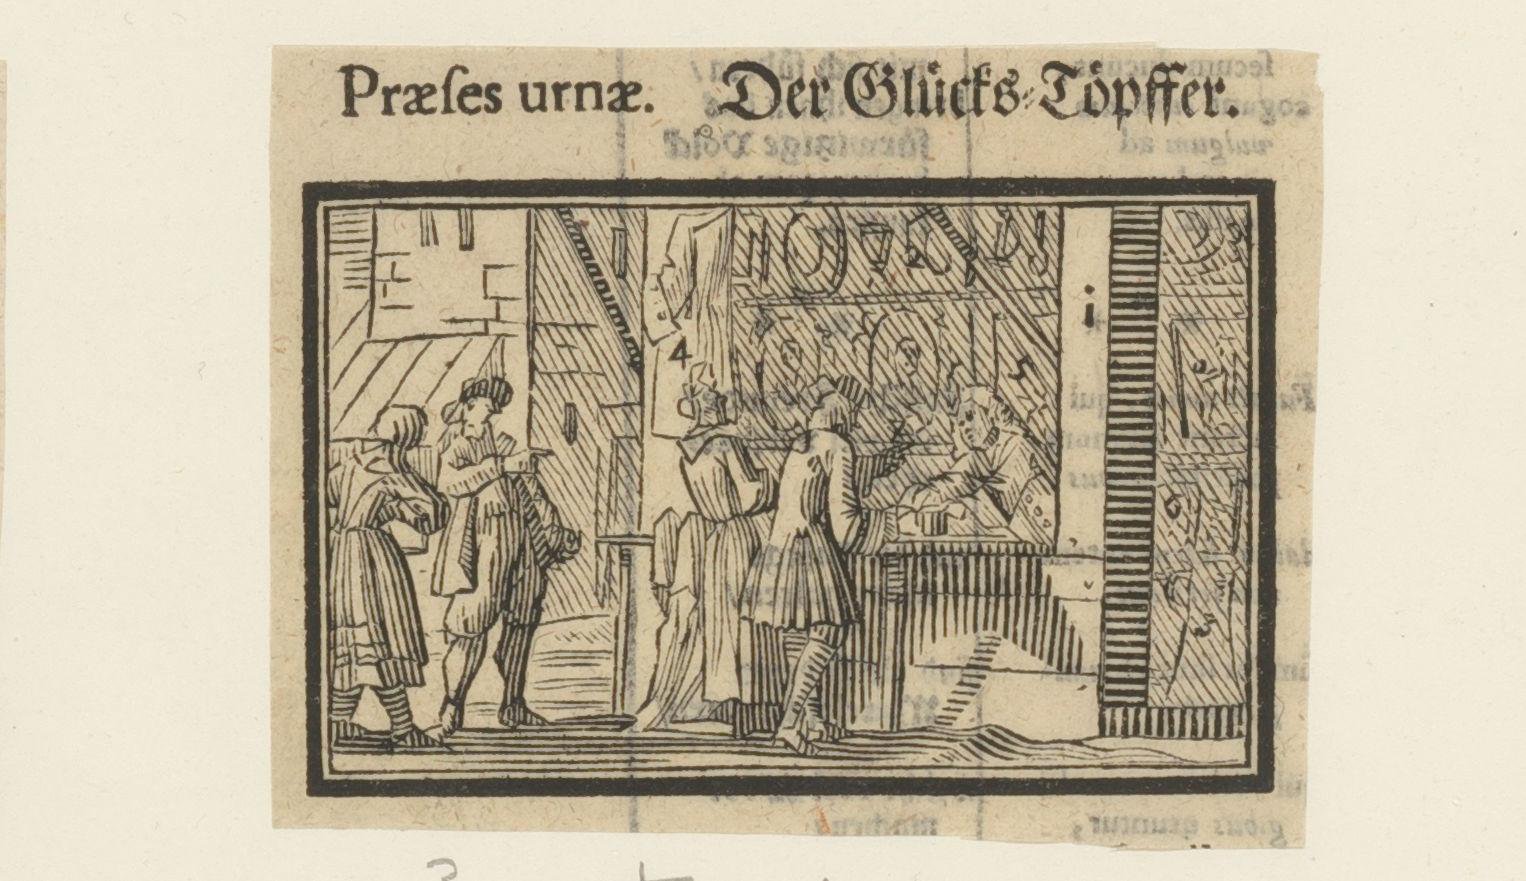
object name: print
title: Tombola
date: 1719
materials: paper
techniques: letterpress printing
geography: nuremberg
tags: raffle, lottery, games of calculation and chance, e.g.: card games, gambling, puzzles, etc.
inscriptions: stamp, collector's mark: Lugt 1641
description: Een kraam waar prijzen te winnen zijn door middel van loten die men uit een pot trekt. In de kraam een uitstalling van te winnen prijzen zoals, zilveren serviesgoed, huisraad van tin en koper, kleding en schilderijen. Onderwerpsrubrieken binnen de Atlas Zeden en Gewoonten: Handel, Nijverheid en Verkeer, Beroep en bedrijf, Complete suites.